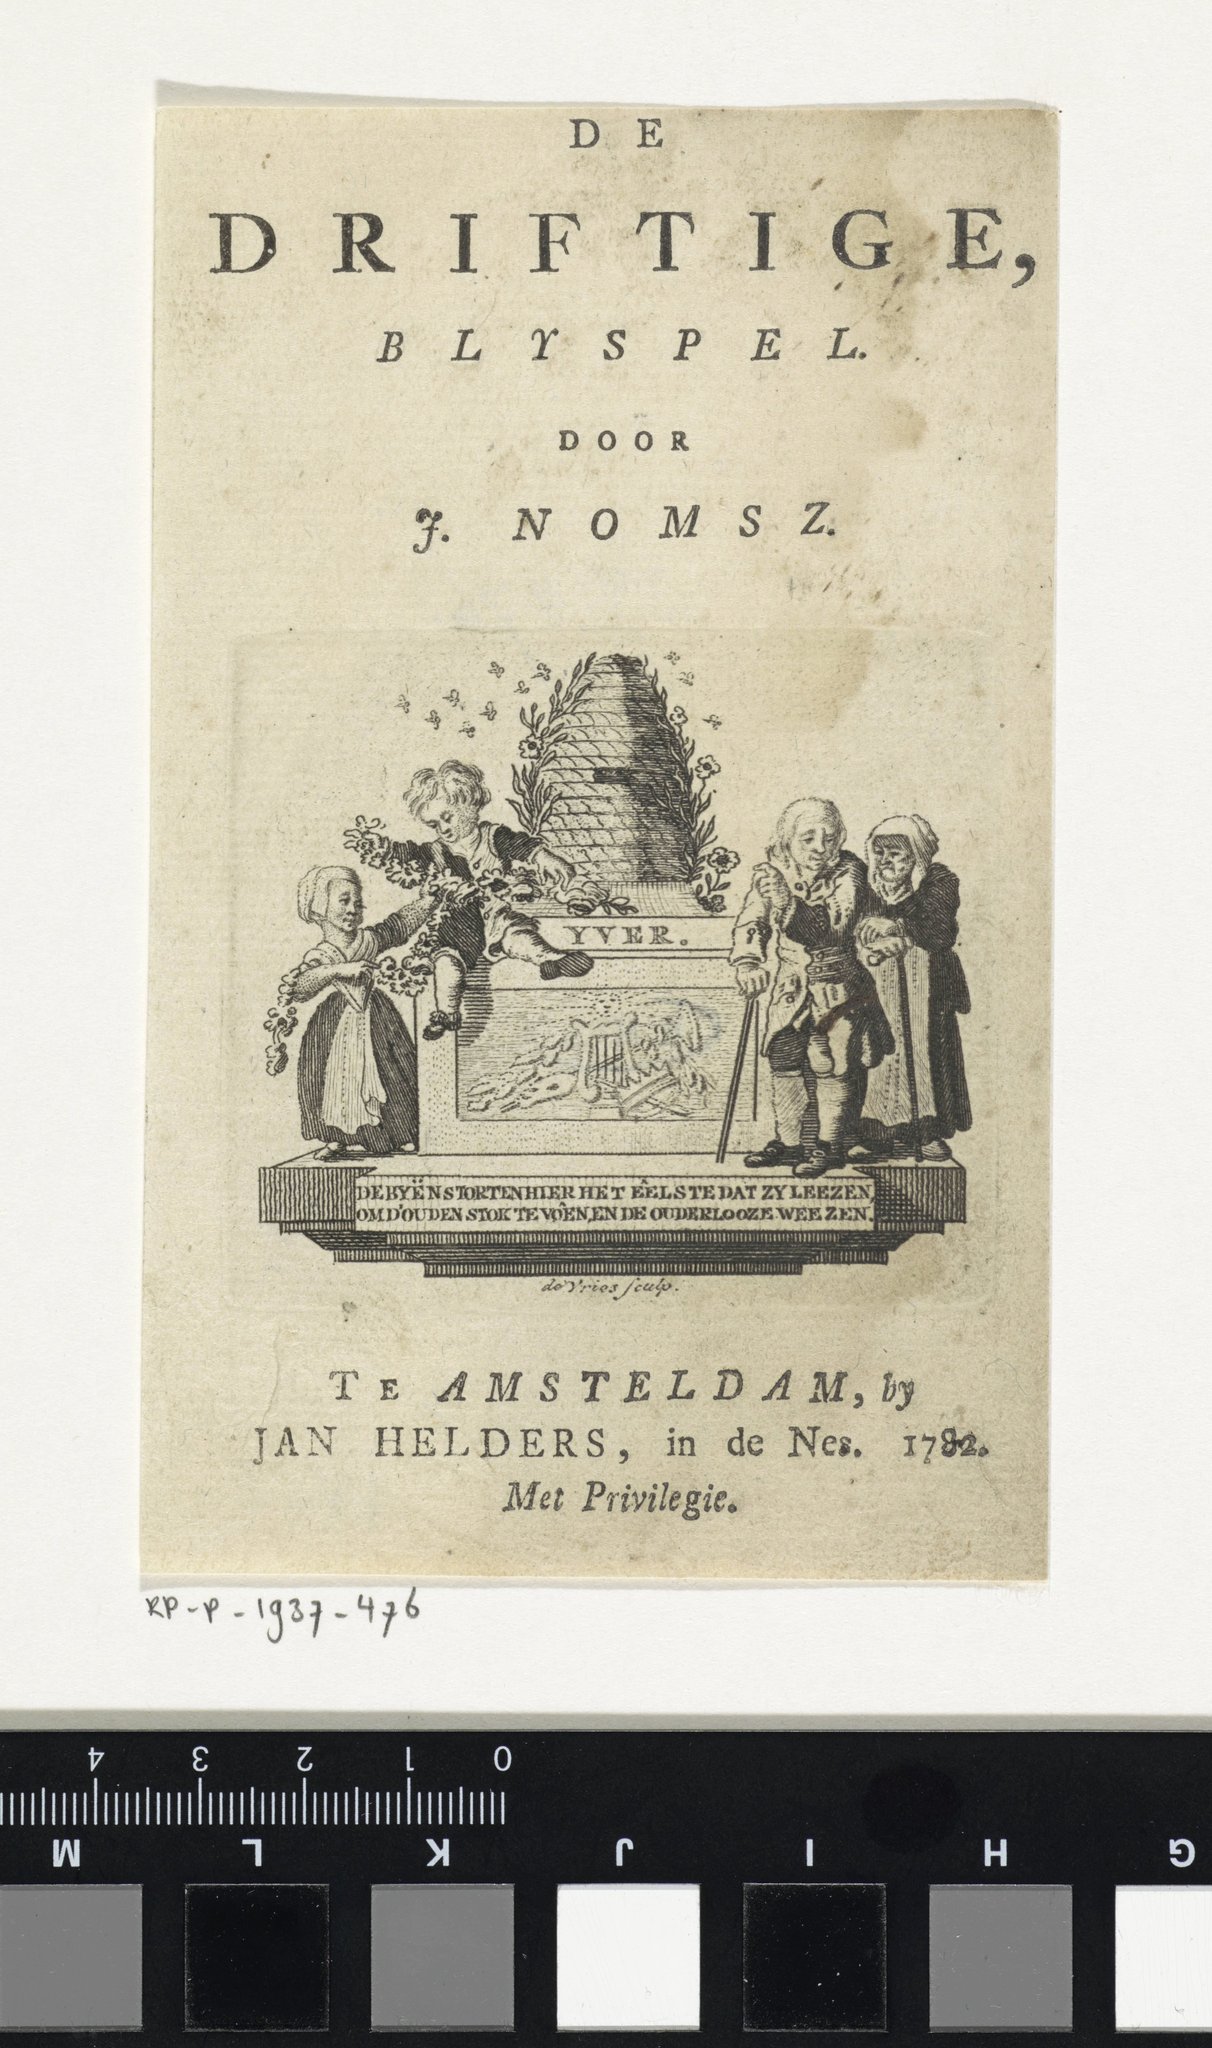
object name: print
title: Titelpagina voor: J. Nomsz, De driftige, blyspel, 1782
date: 1782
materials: paper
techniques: etching, letterpress printing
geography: amsterdam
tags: symbolic representations, allegories and emblems ~ the theatre, bee-hive, young versus old age; young and old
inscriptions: collector's mark: Lugt 2760, collector's mark: Lugt 2228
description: Een oud paar en twee spelende kinderen met bloemenguirlandes bij een bijenkorf op een sokkel, symbool voor de Amsterdamse schouwburg.